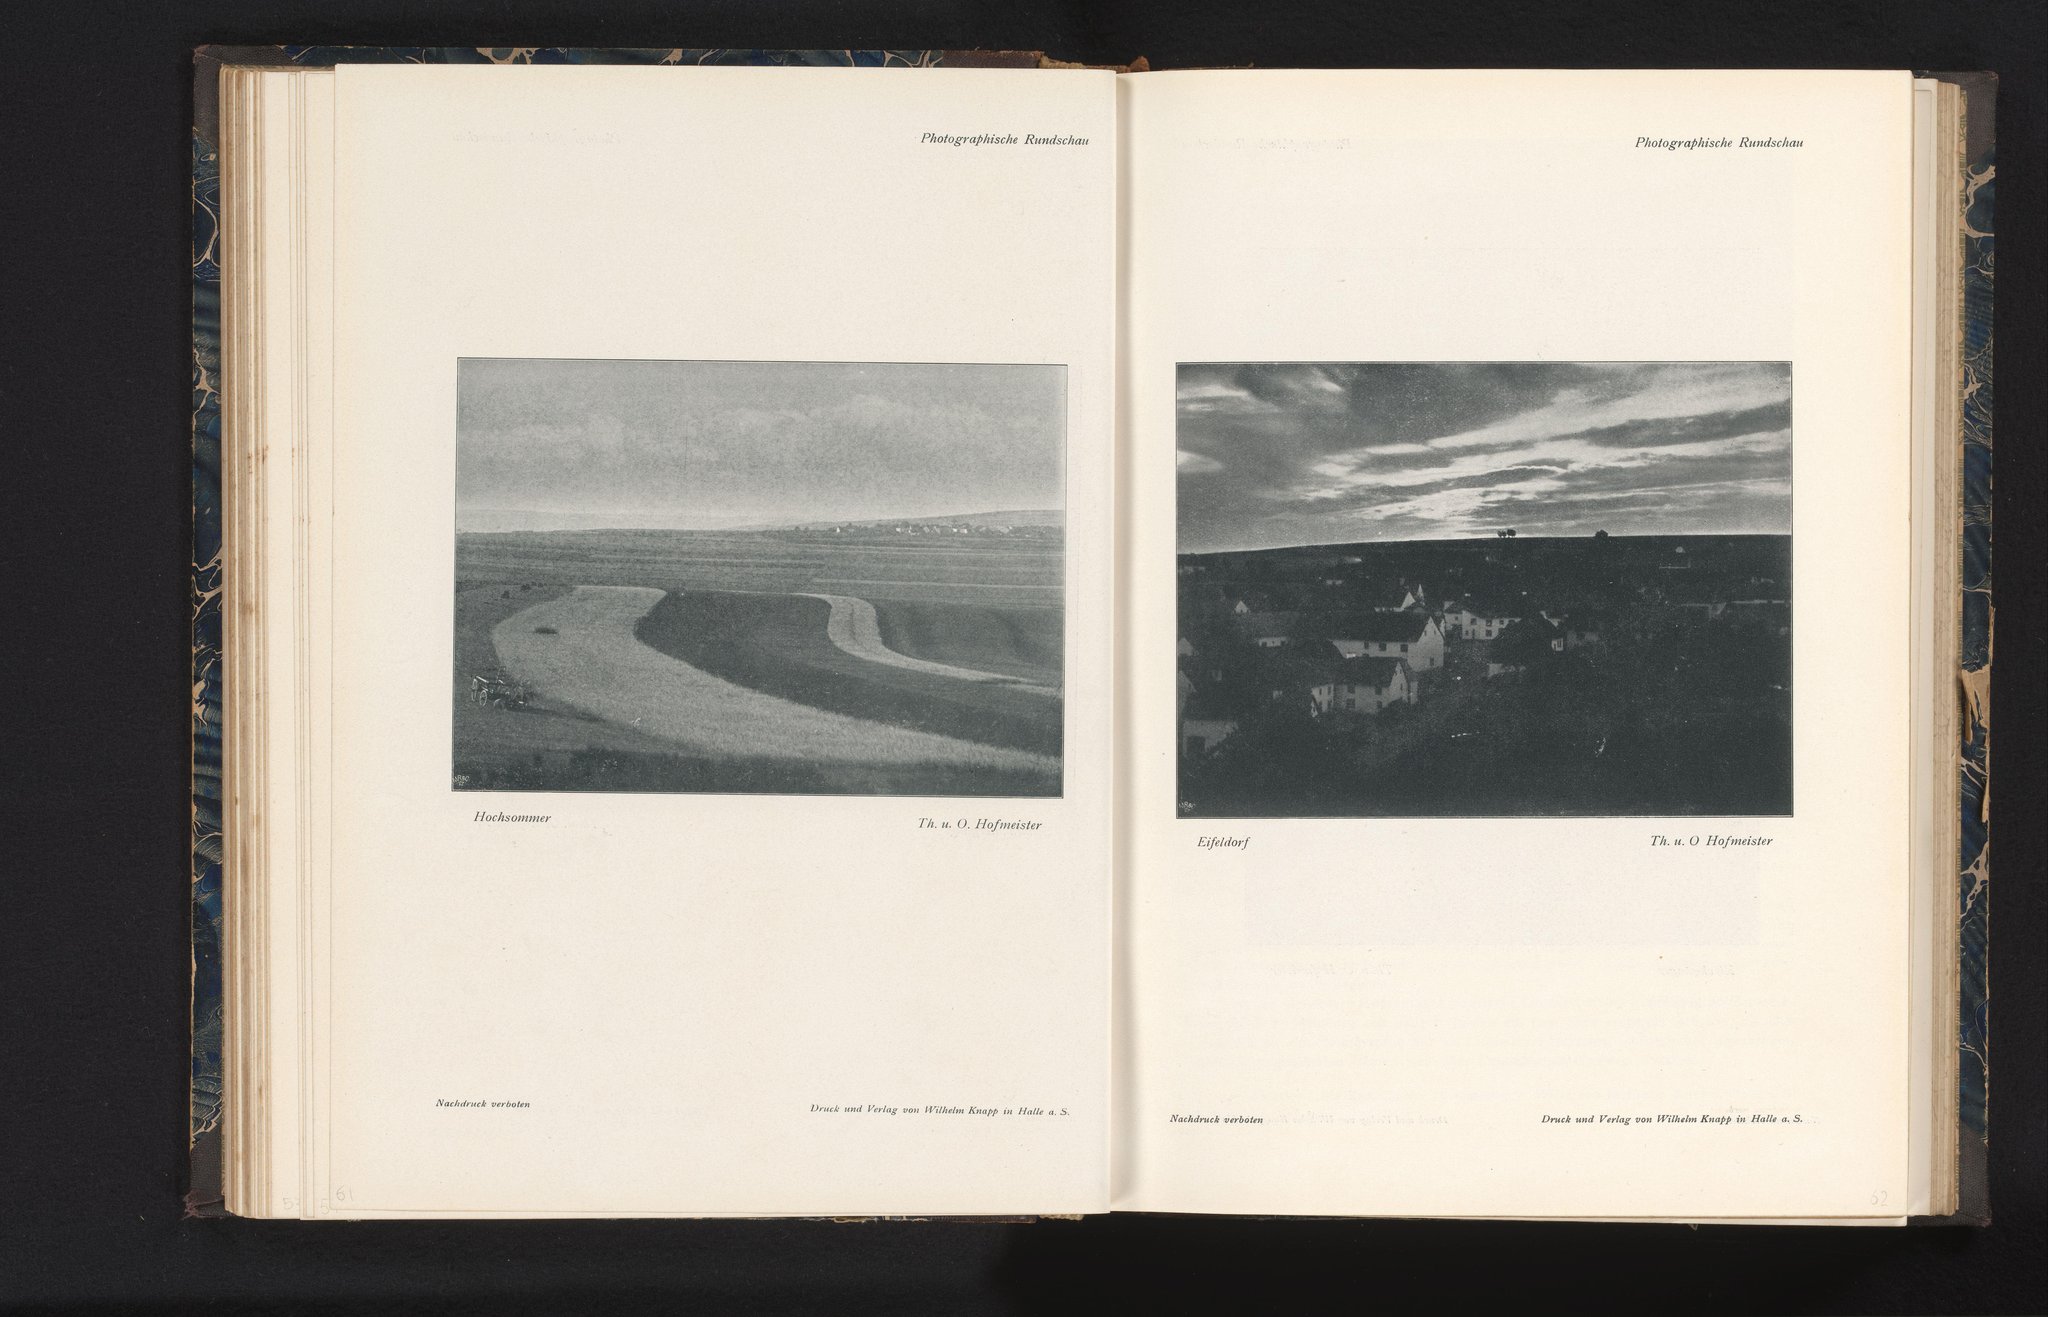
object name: page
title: Gezicht op een landschap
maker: th. u. o. hofmeister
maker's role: fotograaf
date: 1897-1902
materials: paper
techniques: autotype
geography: berlin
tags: landscapes